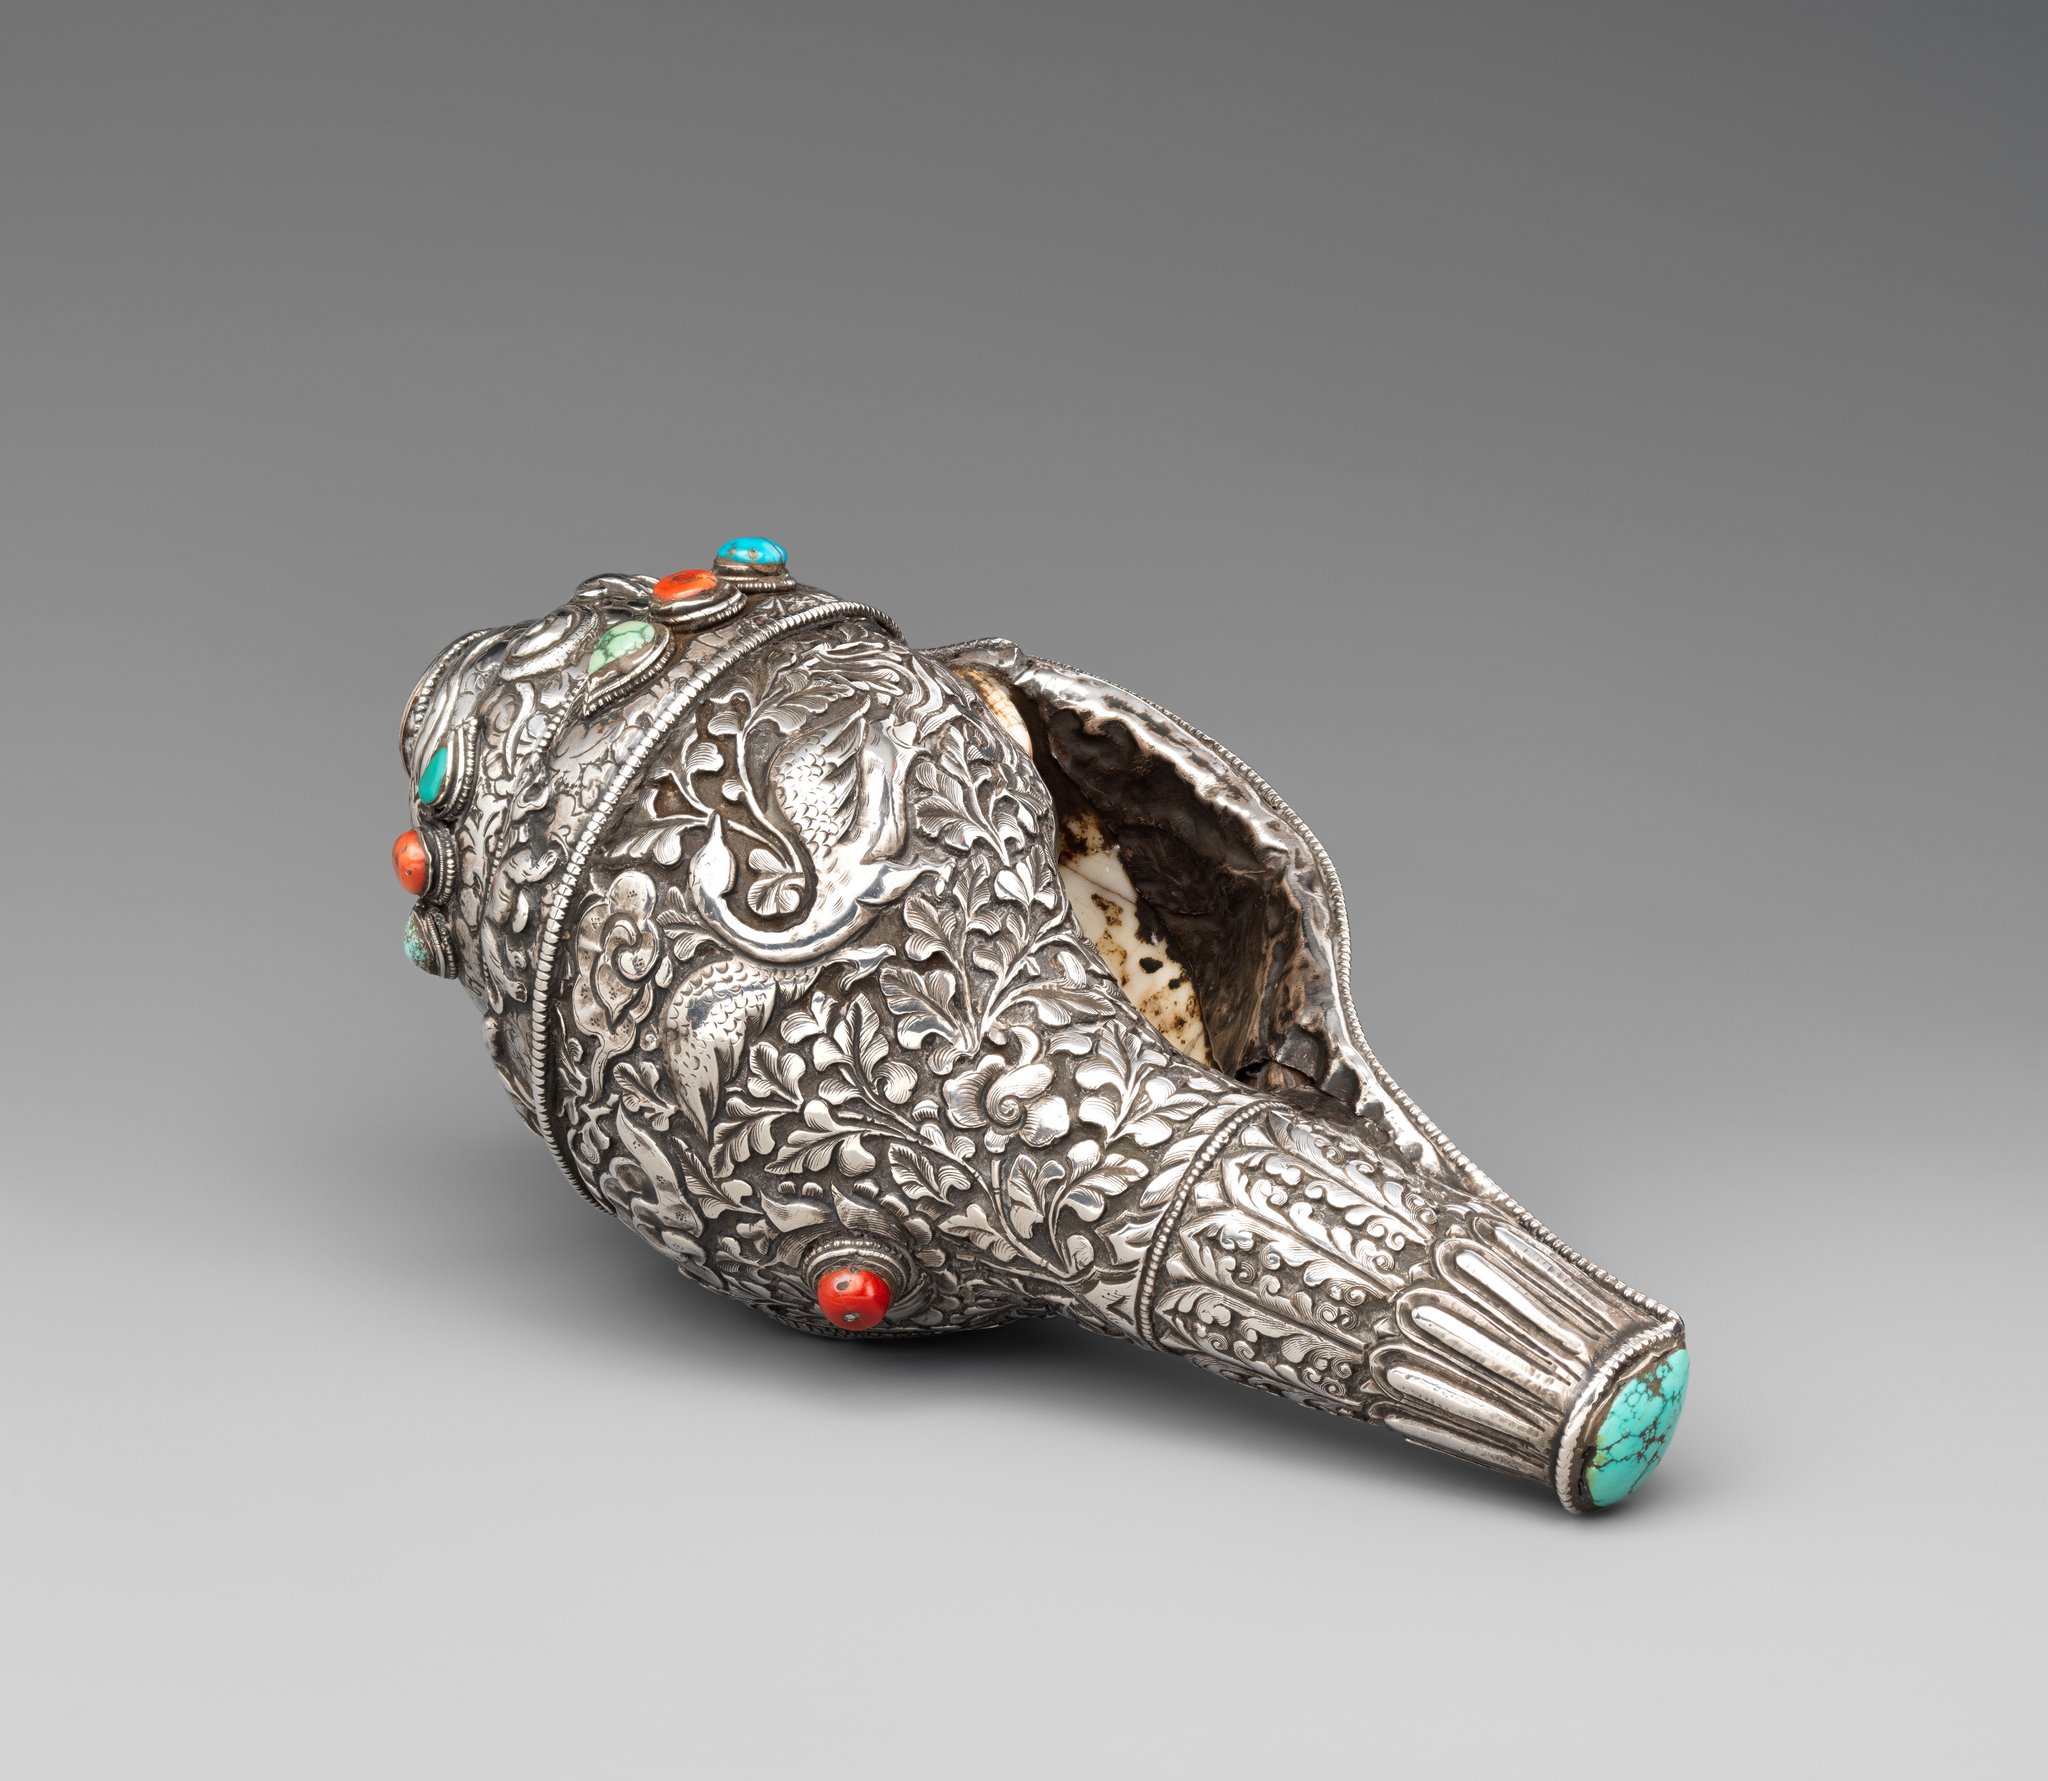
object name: ritual conch shell trumpet dung dkar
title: Ritual Conch Shell Trumpet (Dung-Dkar)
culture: tibetan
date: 1801-1900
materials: coral, shell, silver